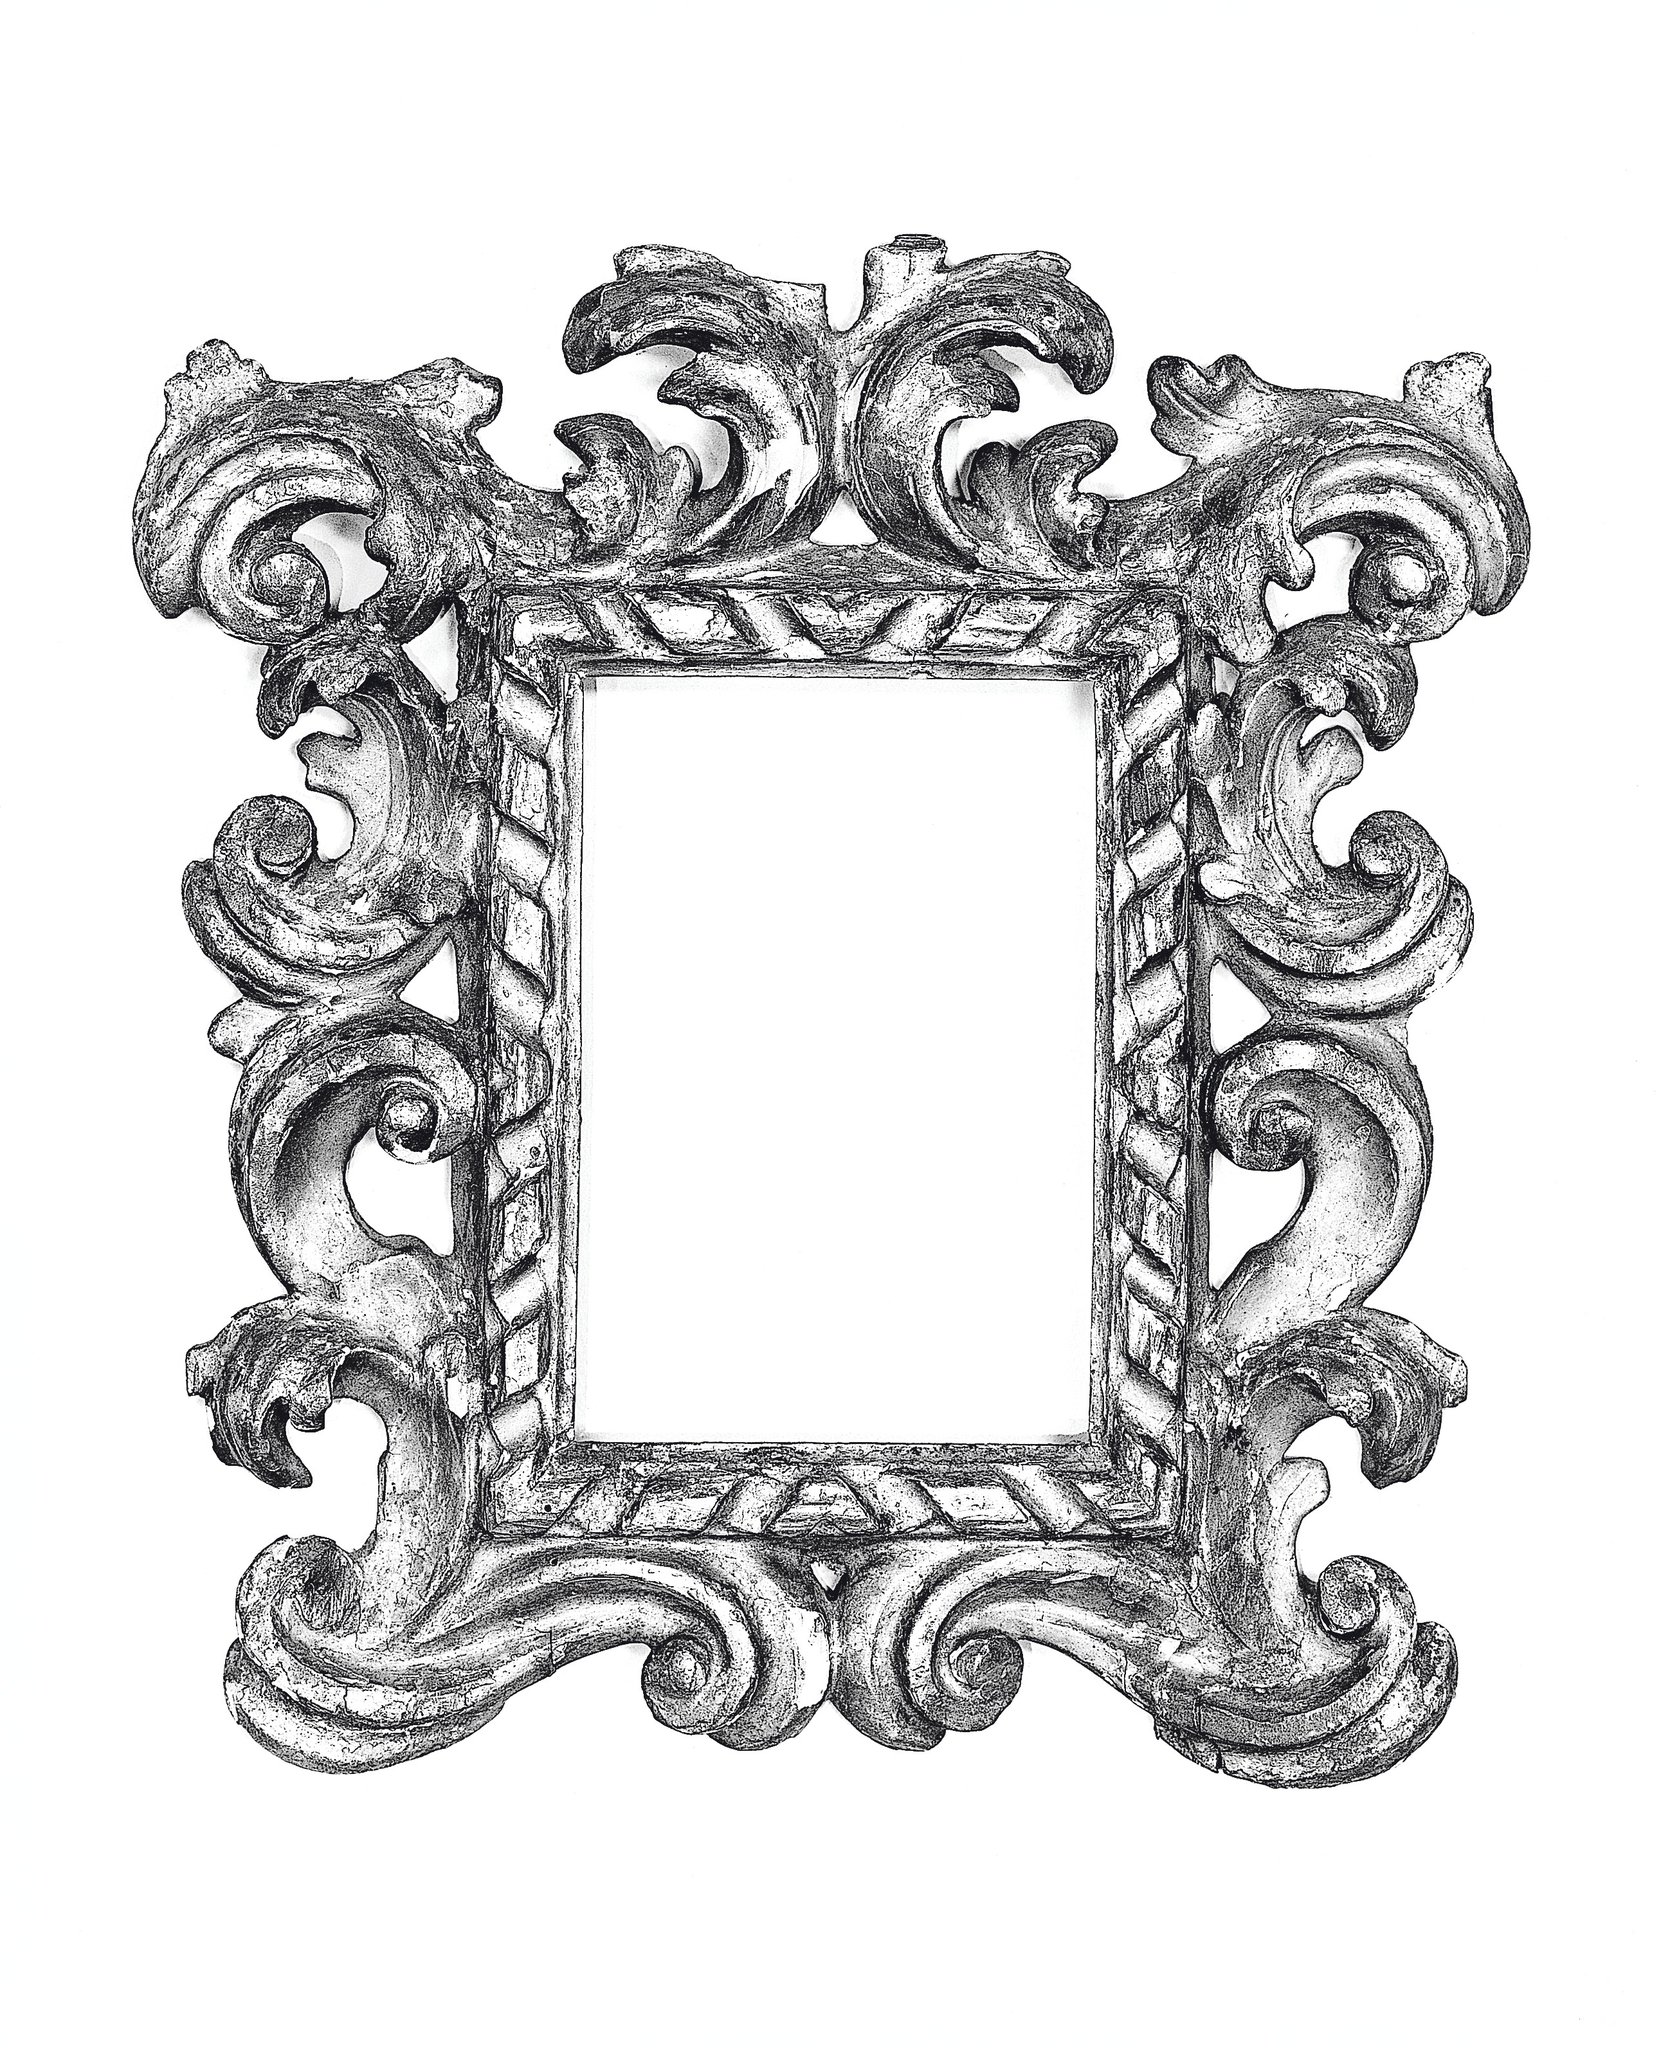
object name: frame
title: Cauliculi frame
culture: italian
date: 1701-1733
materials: wood